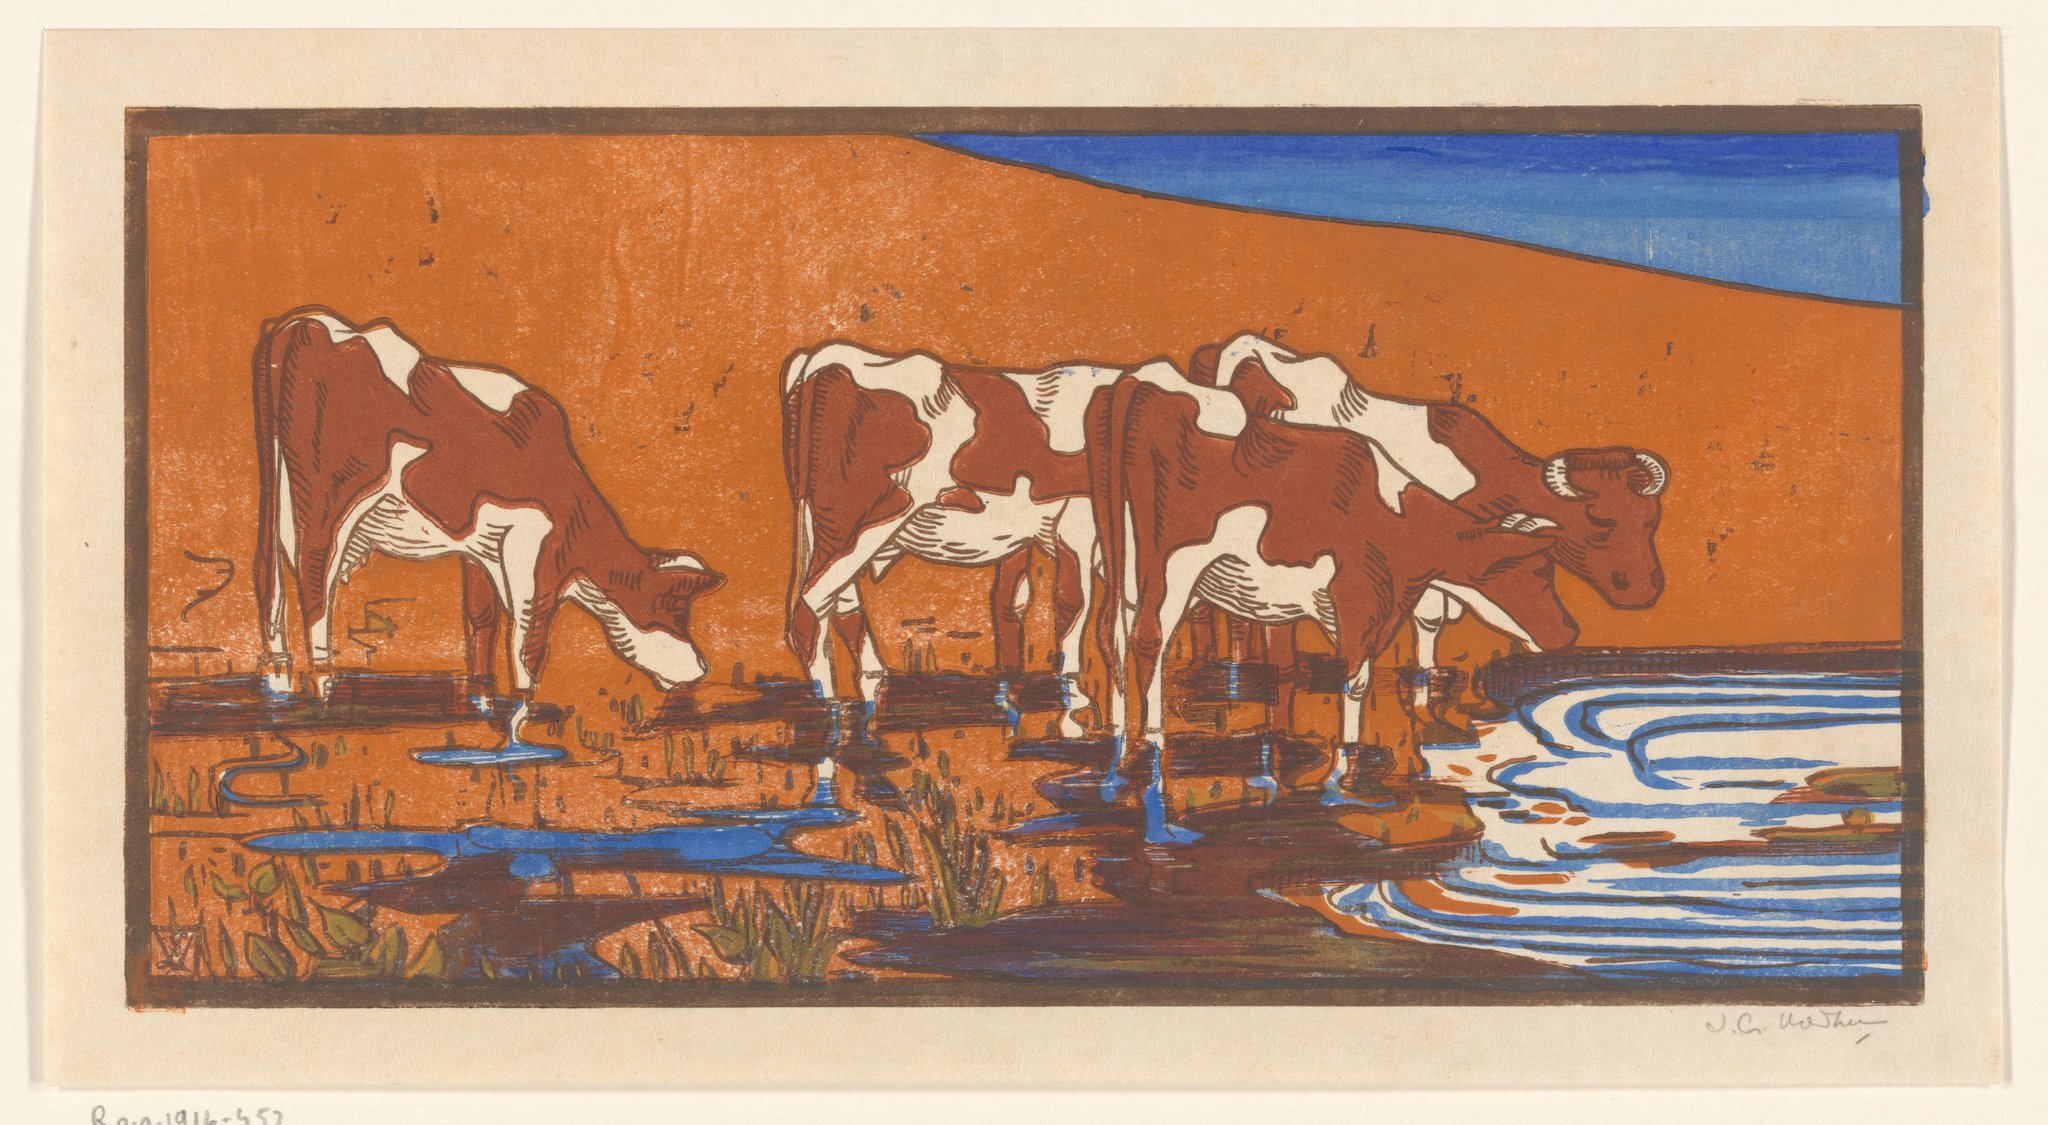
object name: print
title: Koeien aan het water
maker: jacobus gerardus veldheer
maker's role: draughtsman, print maker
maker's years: 1866-1954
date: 1876-1916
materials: paper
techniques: woodcut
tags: cow, pond, pool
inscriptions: collector's mark: Lugt 2233